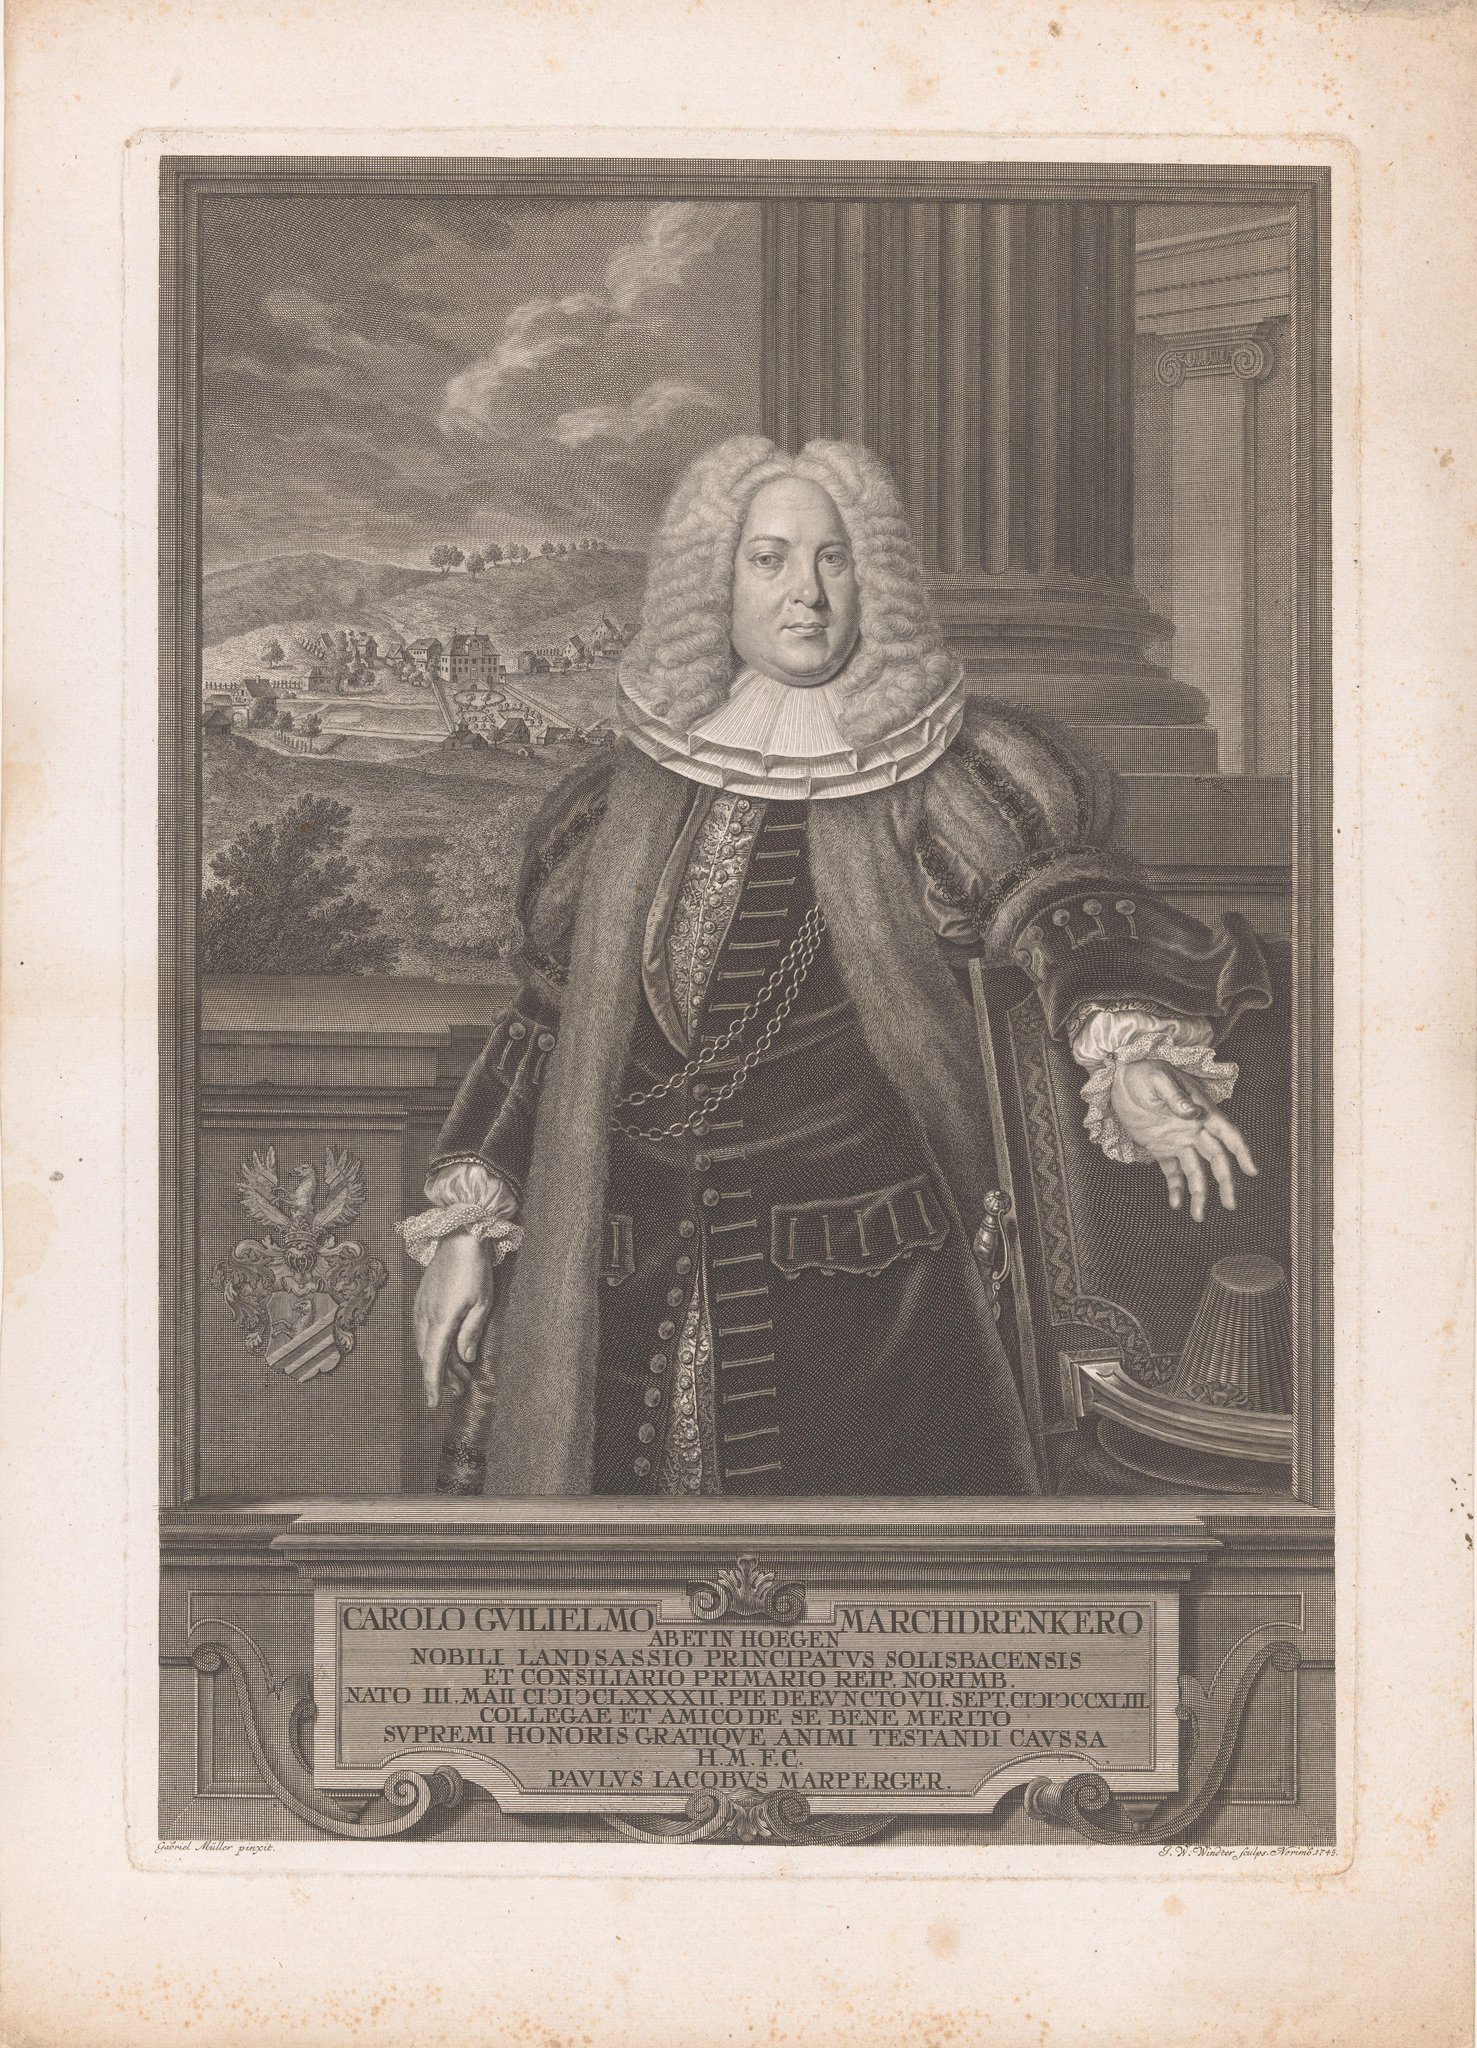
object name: print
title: Portret van Carl Wilhelm Marchdrencker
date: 1745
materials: paper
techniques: engraving, etching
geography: nuremberg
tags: historical persons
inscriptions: collector's mark: Lugt 2228